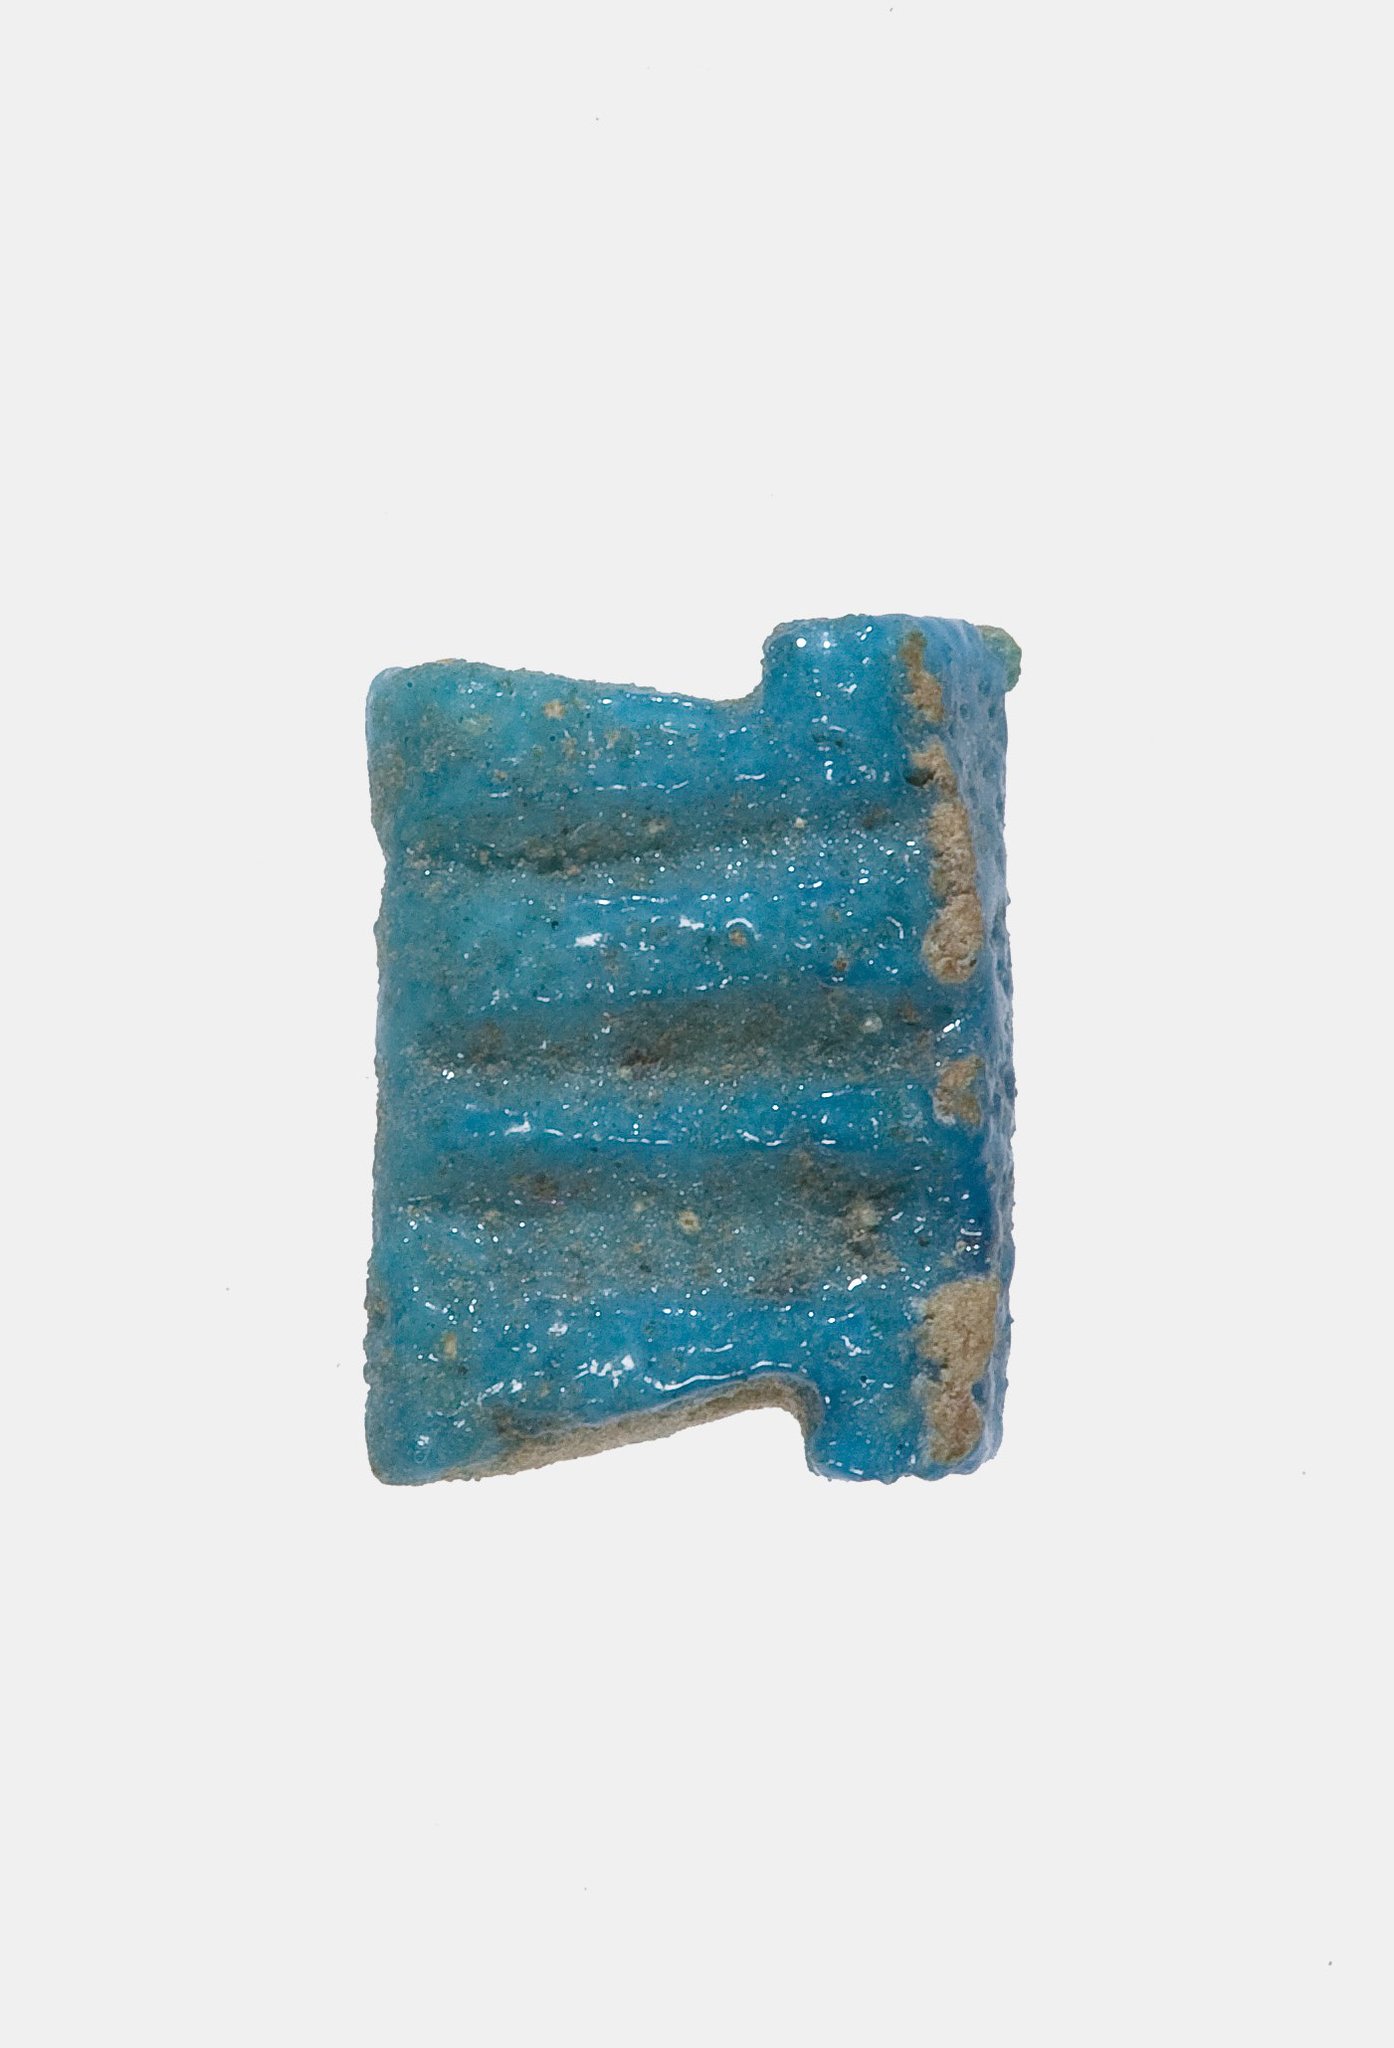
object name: necklace, bead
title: Amulet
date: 1802-1450 BCE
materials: faience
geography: egypt